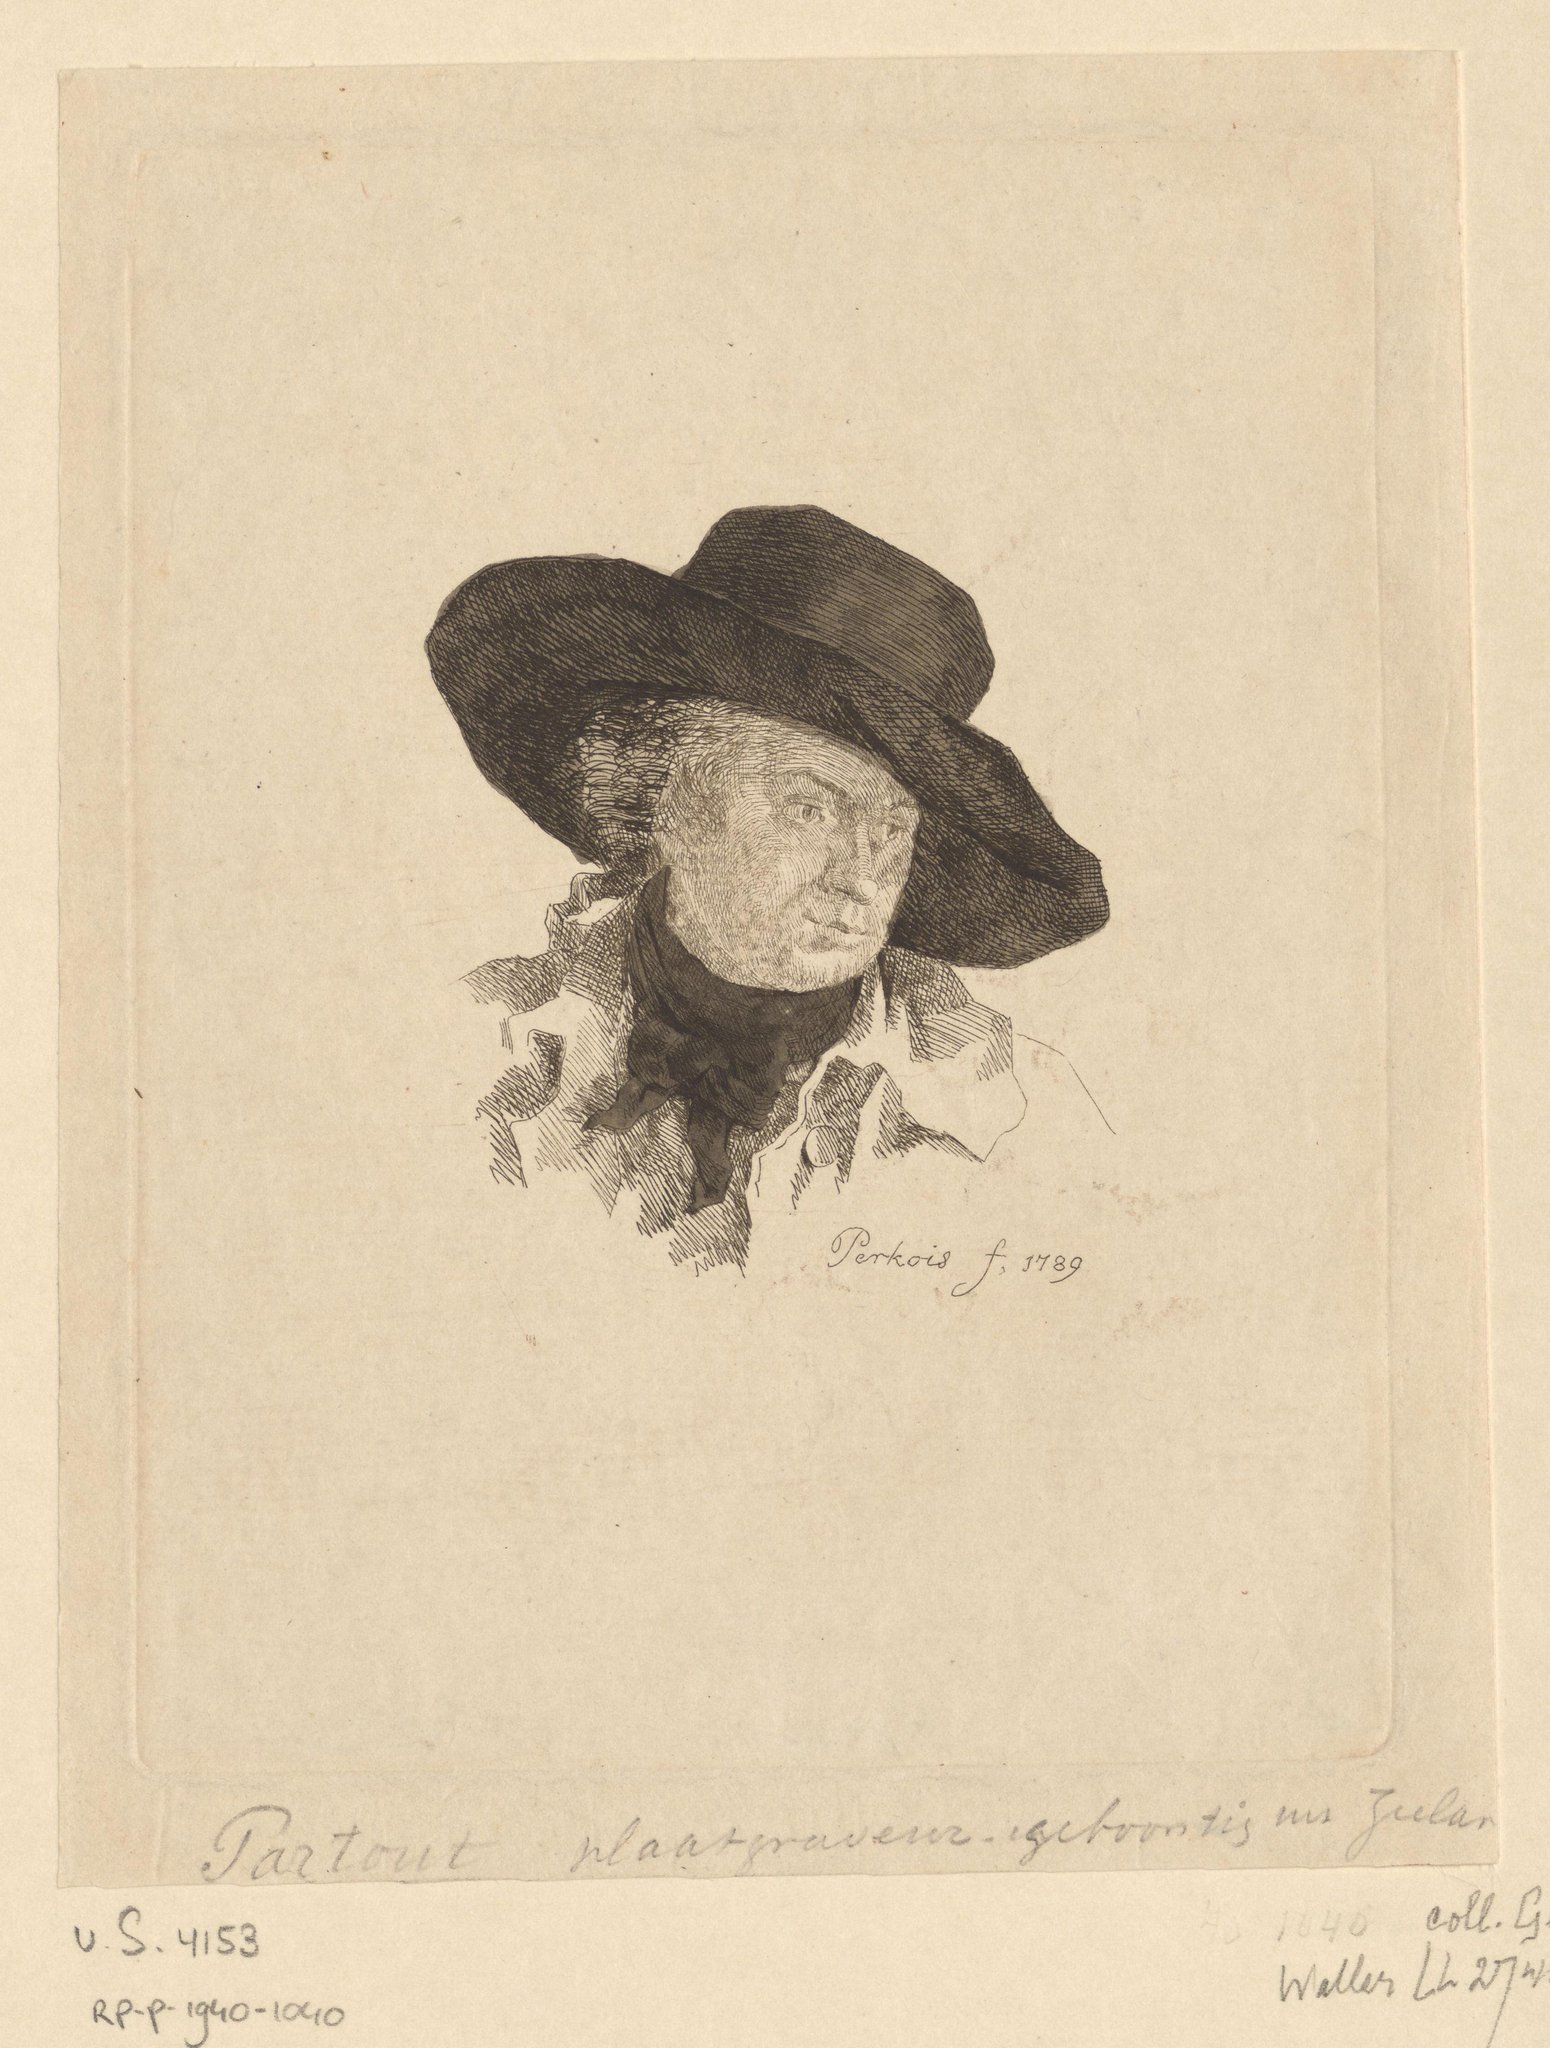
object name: print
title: Portret van H. Partout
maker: jacob perkois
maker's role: draughtsman, print maker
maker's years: 1756-1804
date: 1789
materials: ink, paper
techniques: brush, etching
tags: print maker, h. partout, historical persons, portrait, self-portrait of graphic artist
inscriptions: collector's mark: Lugt 2228, collector's mark: Lugt 2760